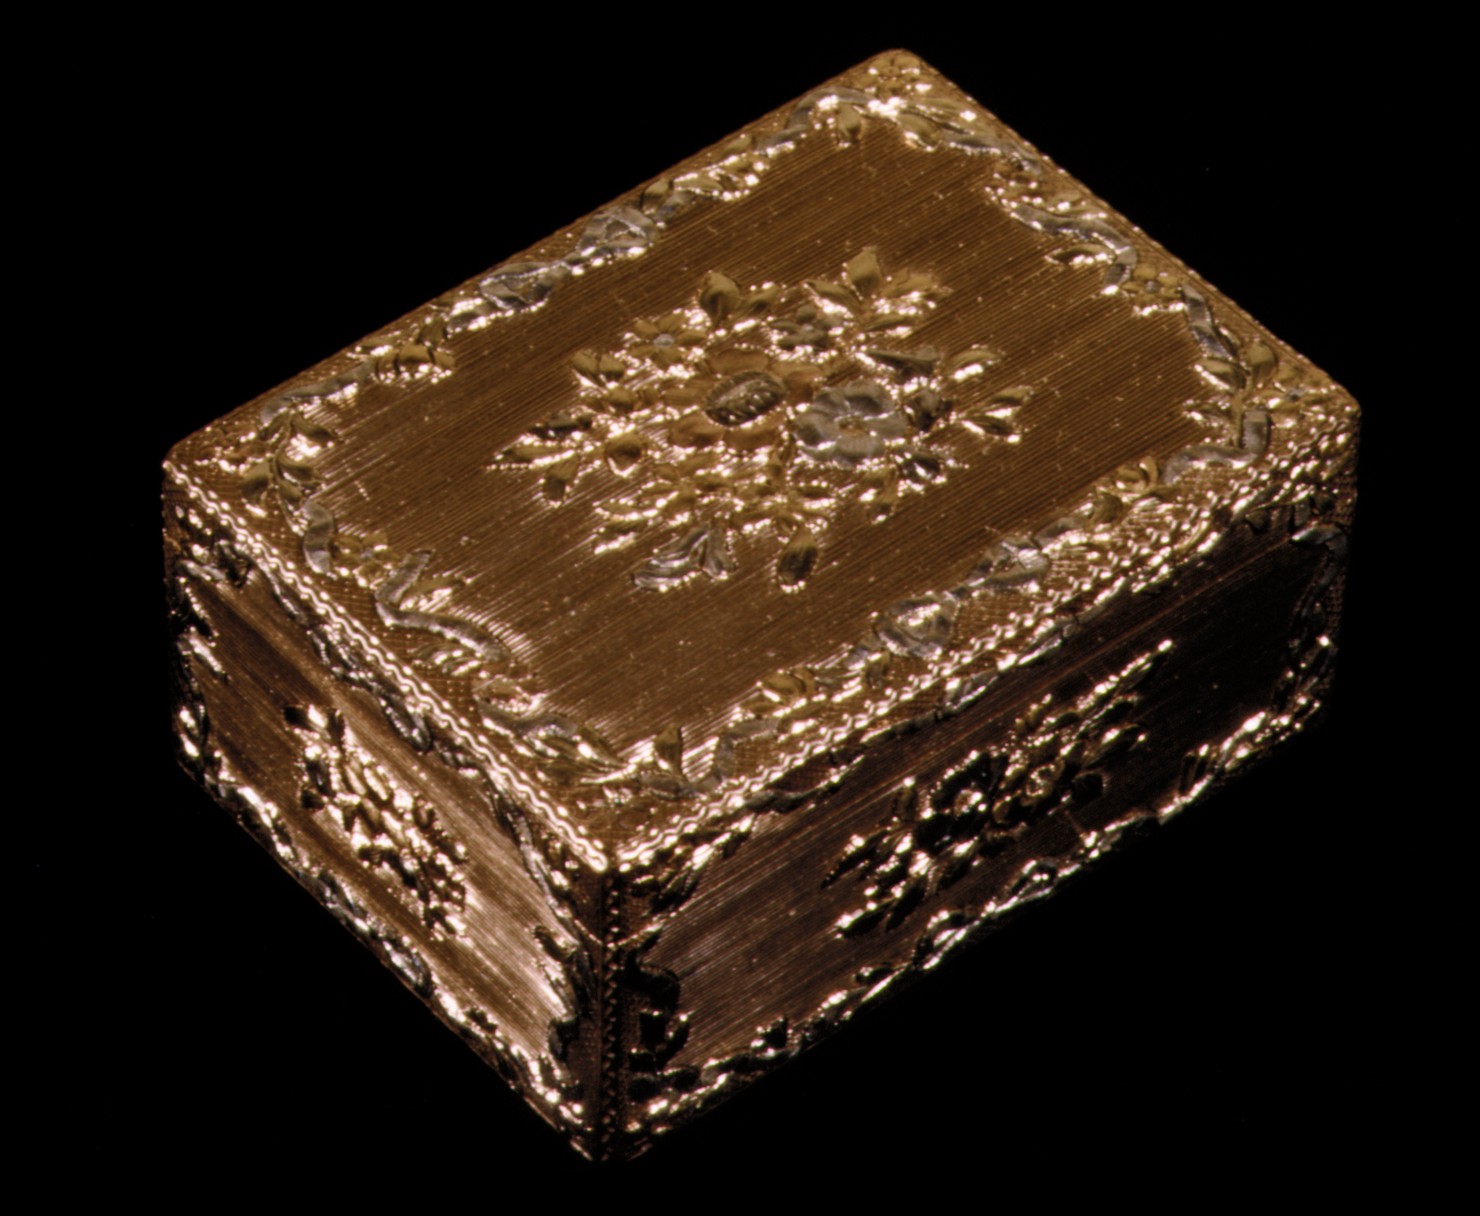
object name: snuffbox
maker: charles le bastier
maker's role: maker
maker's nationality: french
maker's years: 1724-1783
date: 1758-1759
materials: gold